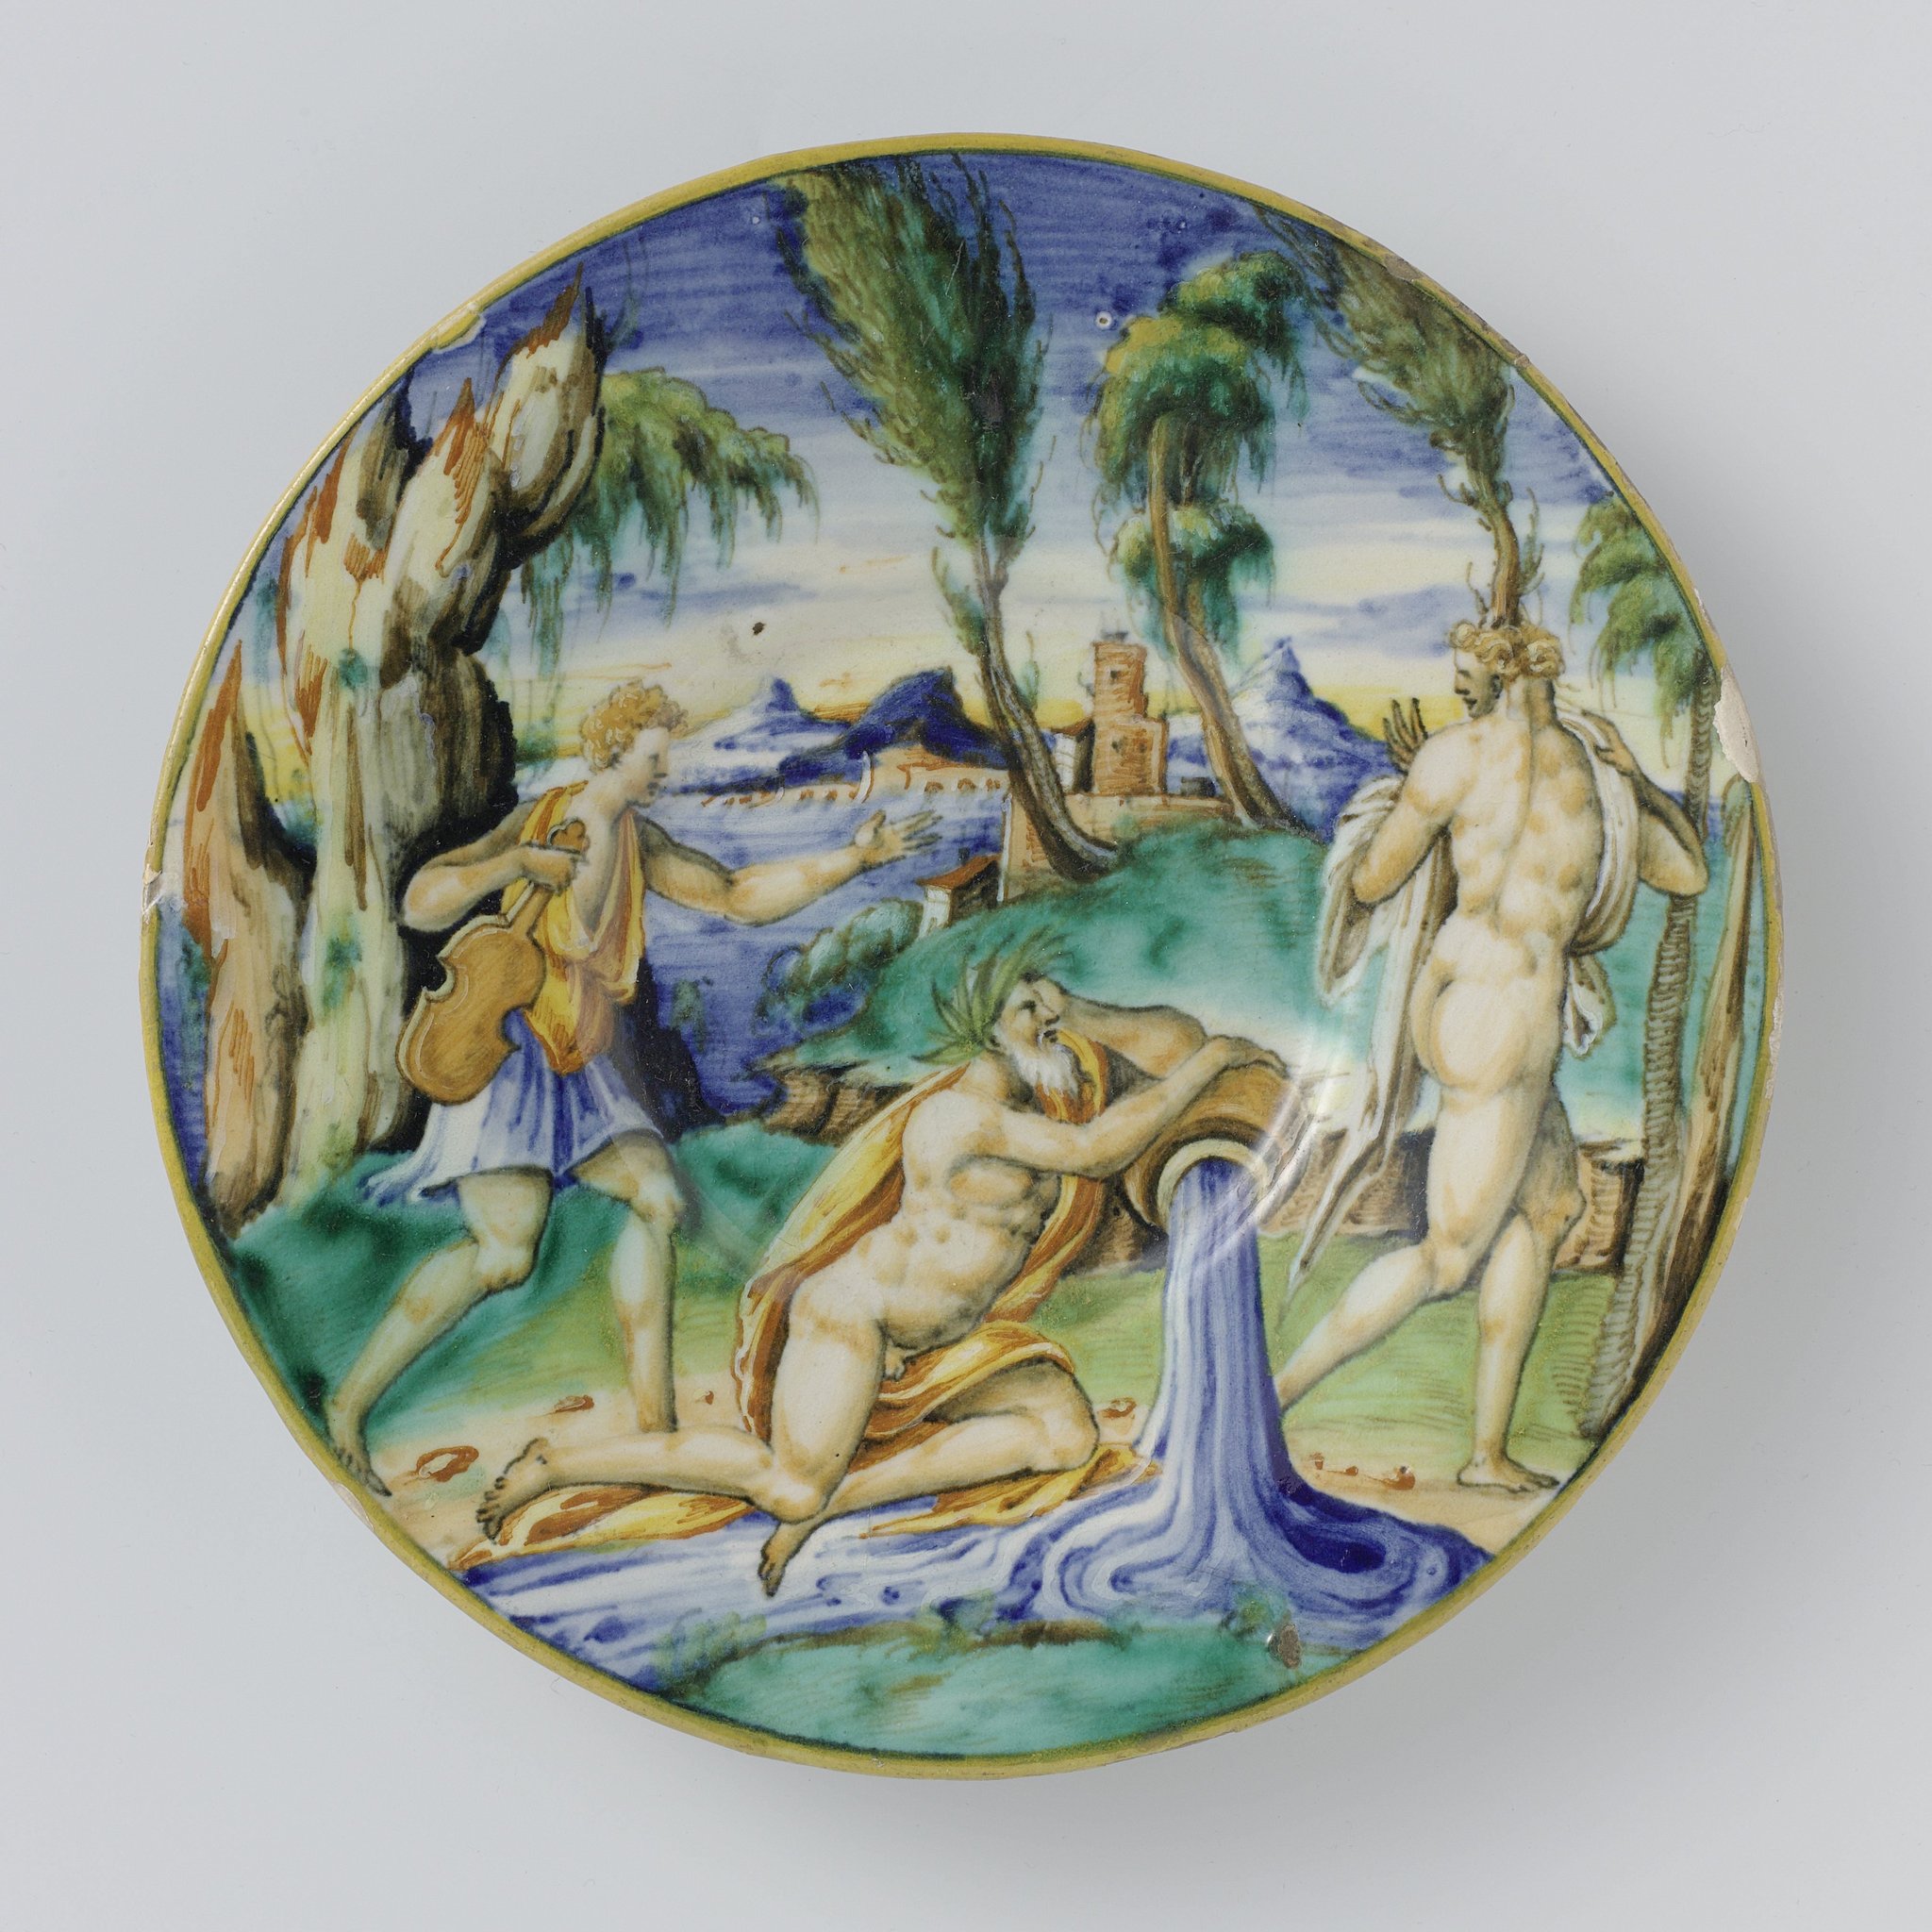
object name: plate dish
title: Plate with Apollo and Daphne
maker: Anonymous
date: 1550-1560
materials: earthenware, glaze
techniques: maiolica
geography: pesaro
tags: daphne changed into a laurel-tree: while fleeing from apollo, daphne is changed into a laurel-tree by her father peneus (ovid, metamorphoses i 548)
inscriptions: inscription: ‘Vidio narra de Dafano e appolo’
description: Bord van veelkleurig beschilderde majolica. Op het bord een voorstelling van Daphne die verandert in een laurier, achtervolgd door Apollo, terwijl haar vader, de riviergod Peneus, toekijkt. Op de achterzijde van het bord het opschrift: "Vidio narra de Dafano e appolo" geschilderd.